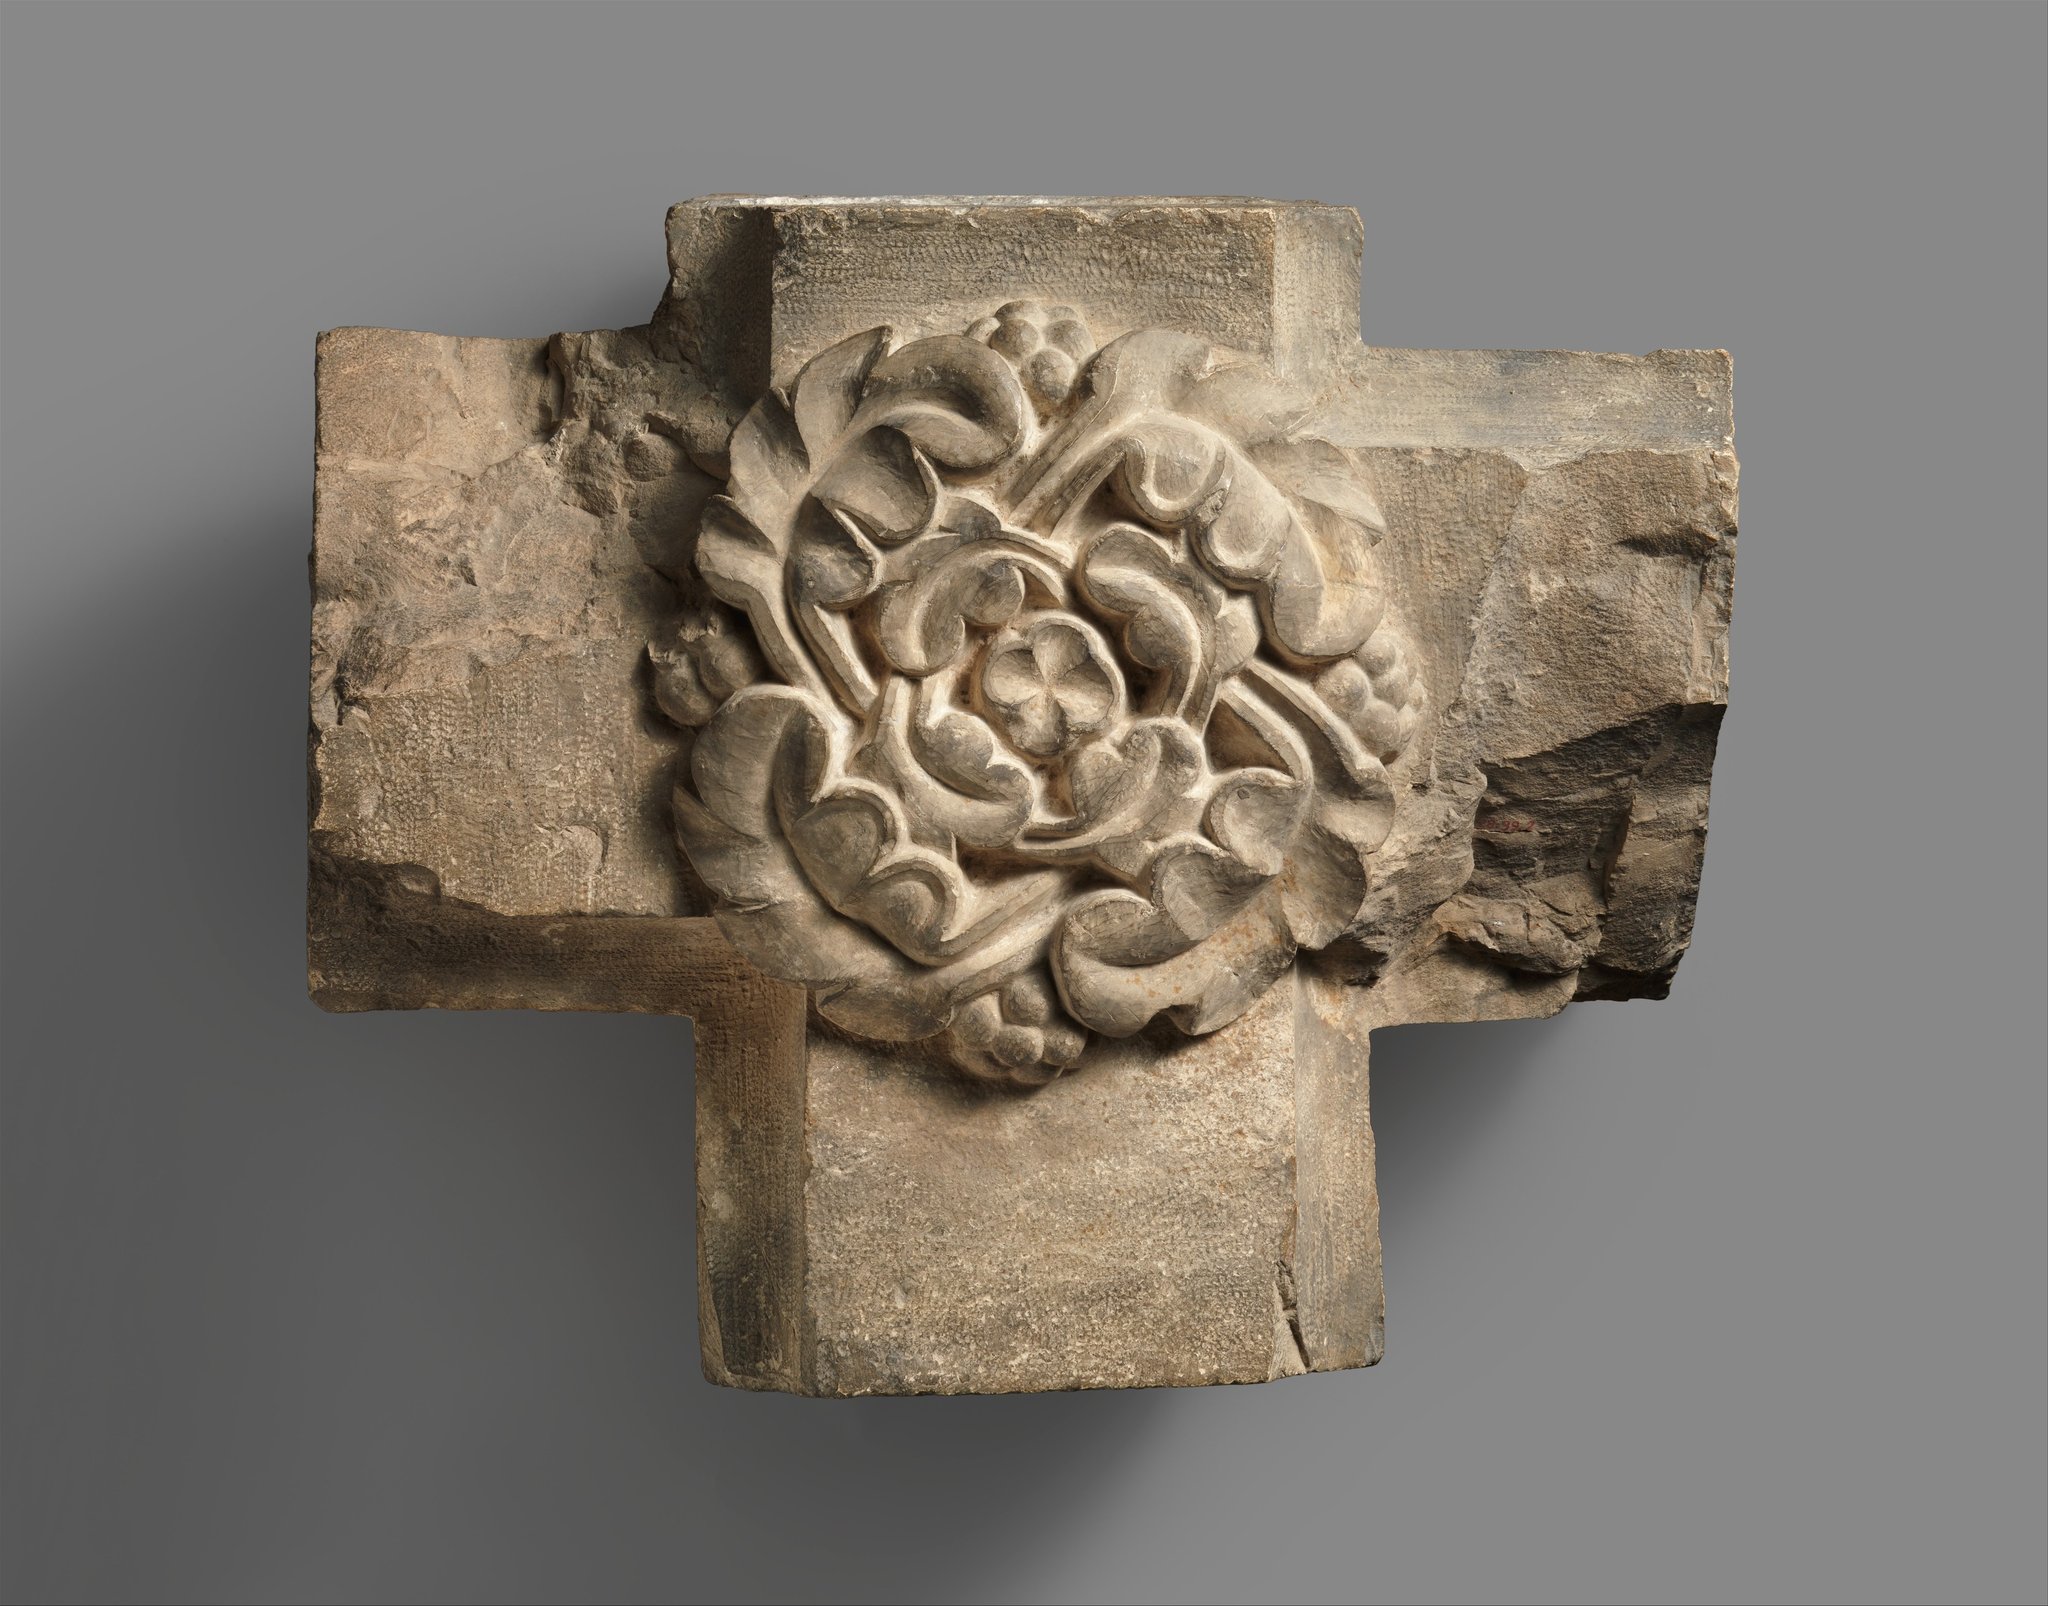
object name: keystone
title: Limestone Keystone from a Vaulted Ceiling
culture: german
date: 1220-1230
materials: limestone